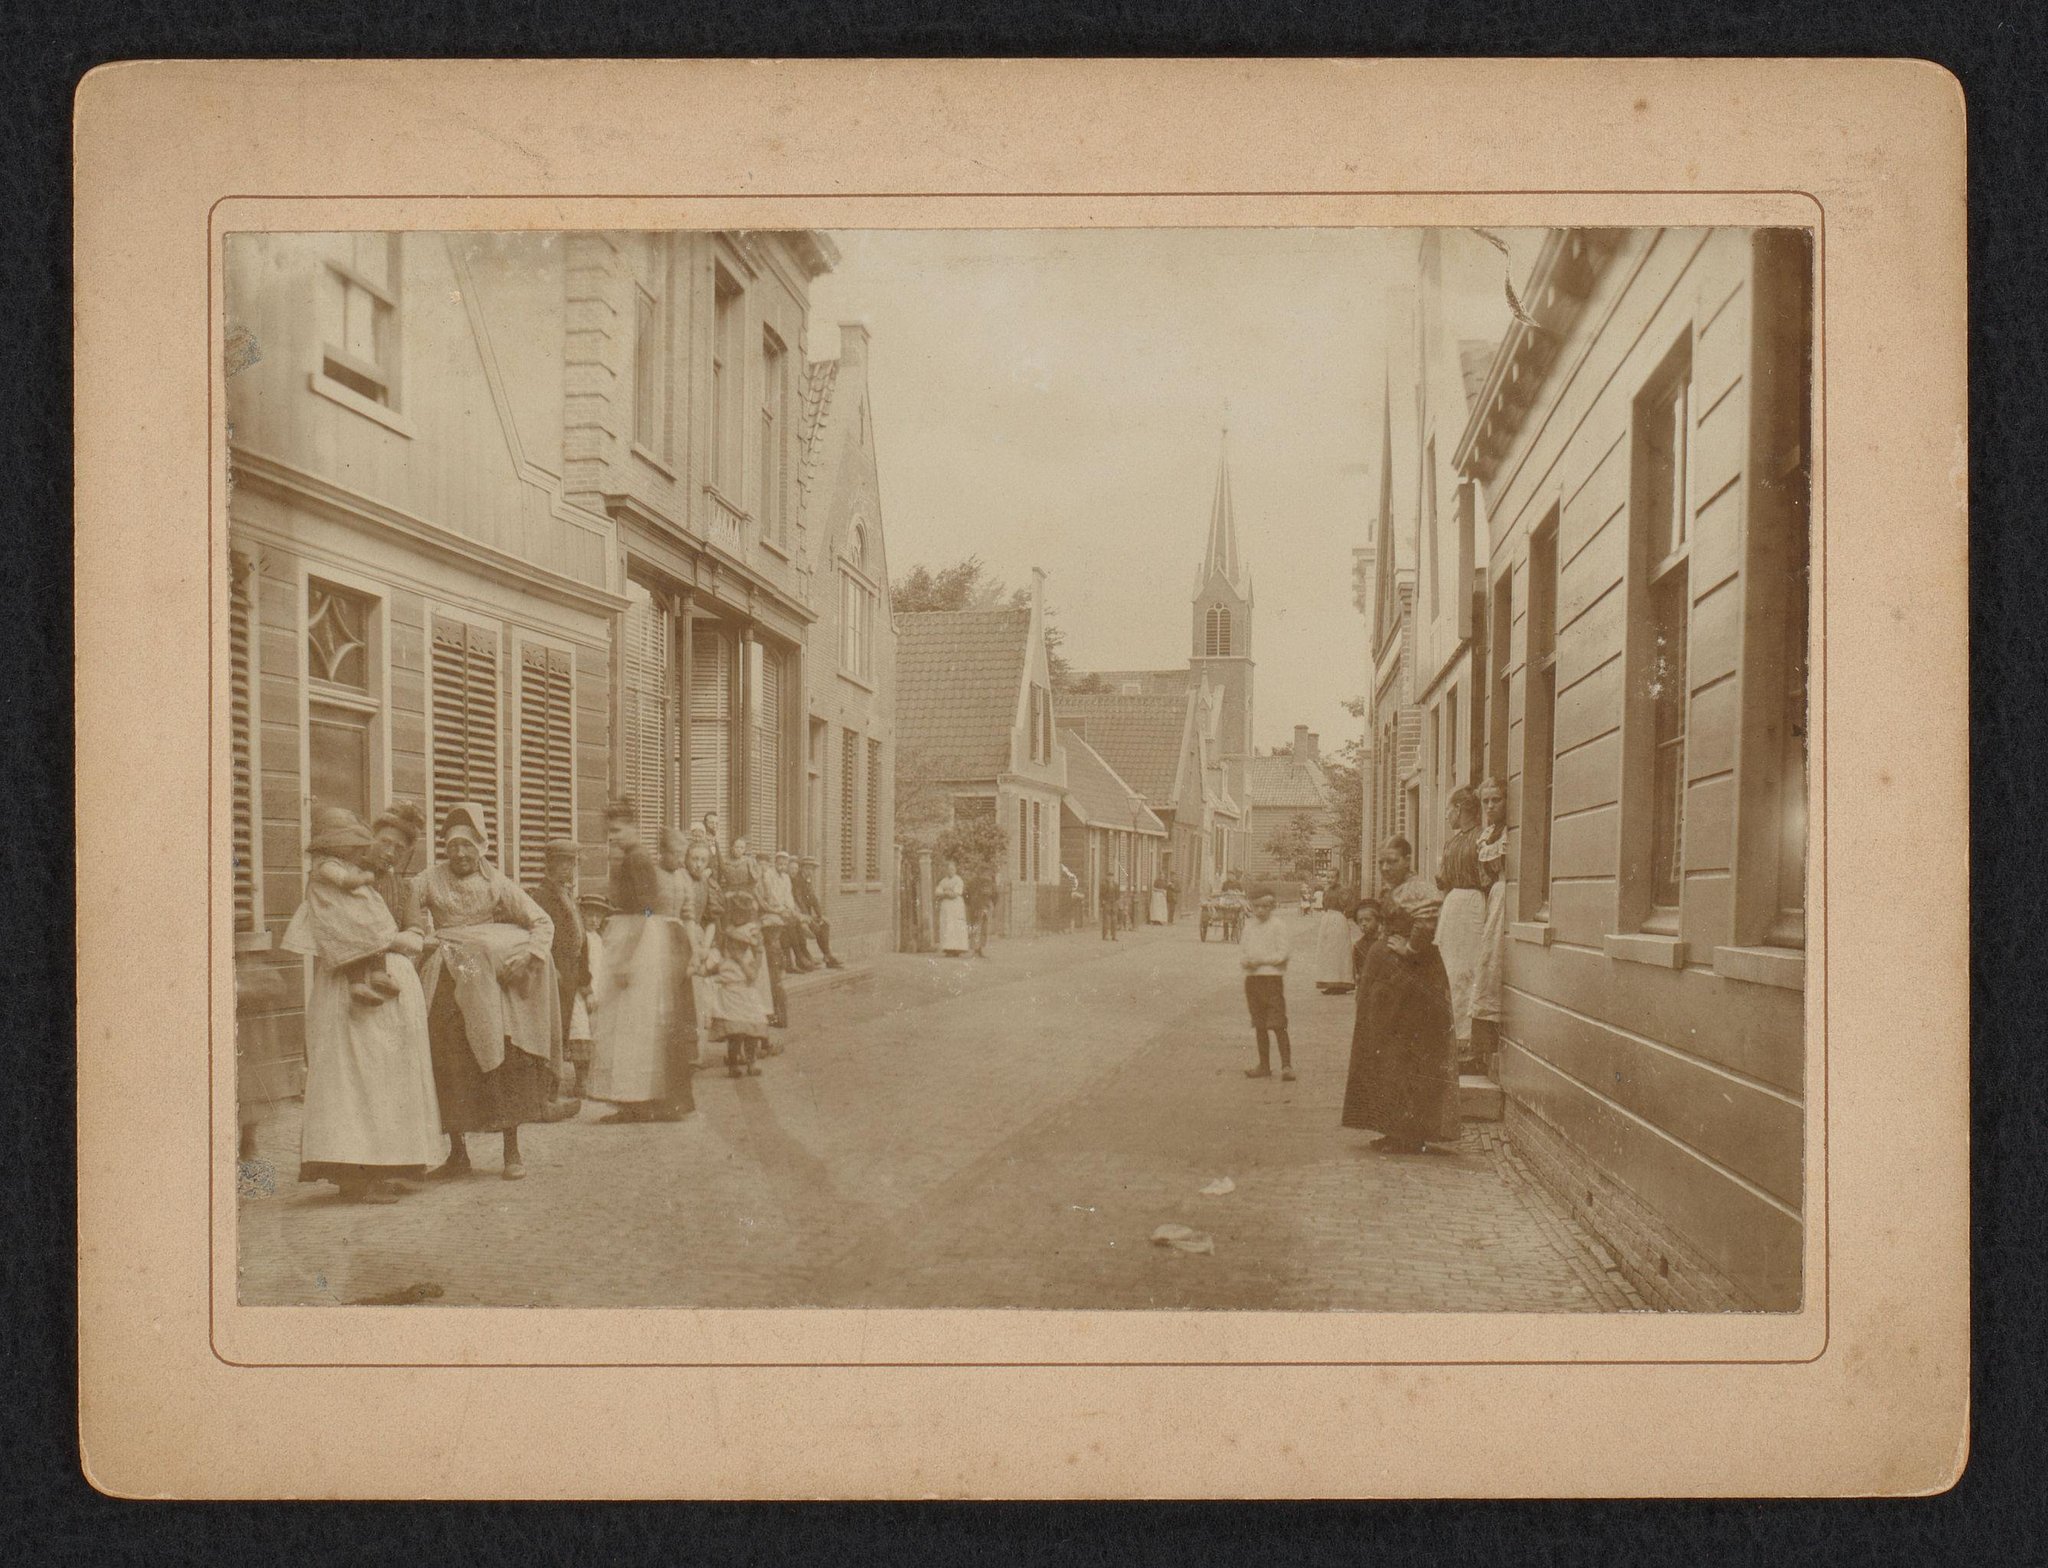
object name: photograph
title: Straat in Krommenie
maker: coenraad jacob snooij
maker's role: publisher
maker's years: 1874-1972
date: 1895-1900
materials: paper, cardboard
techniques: collodion silver print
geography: krommenie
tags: street